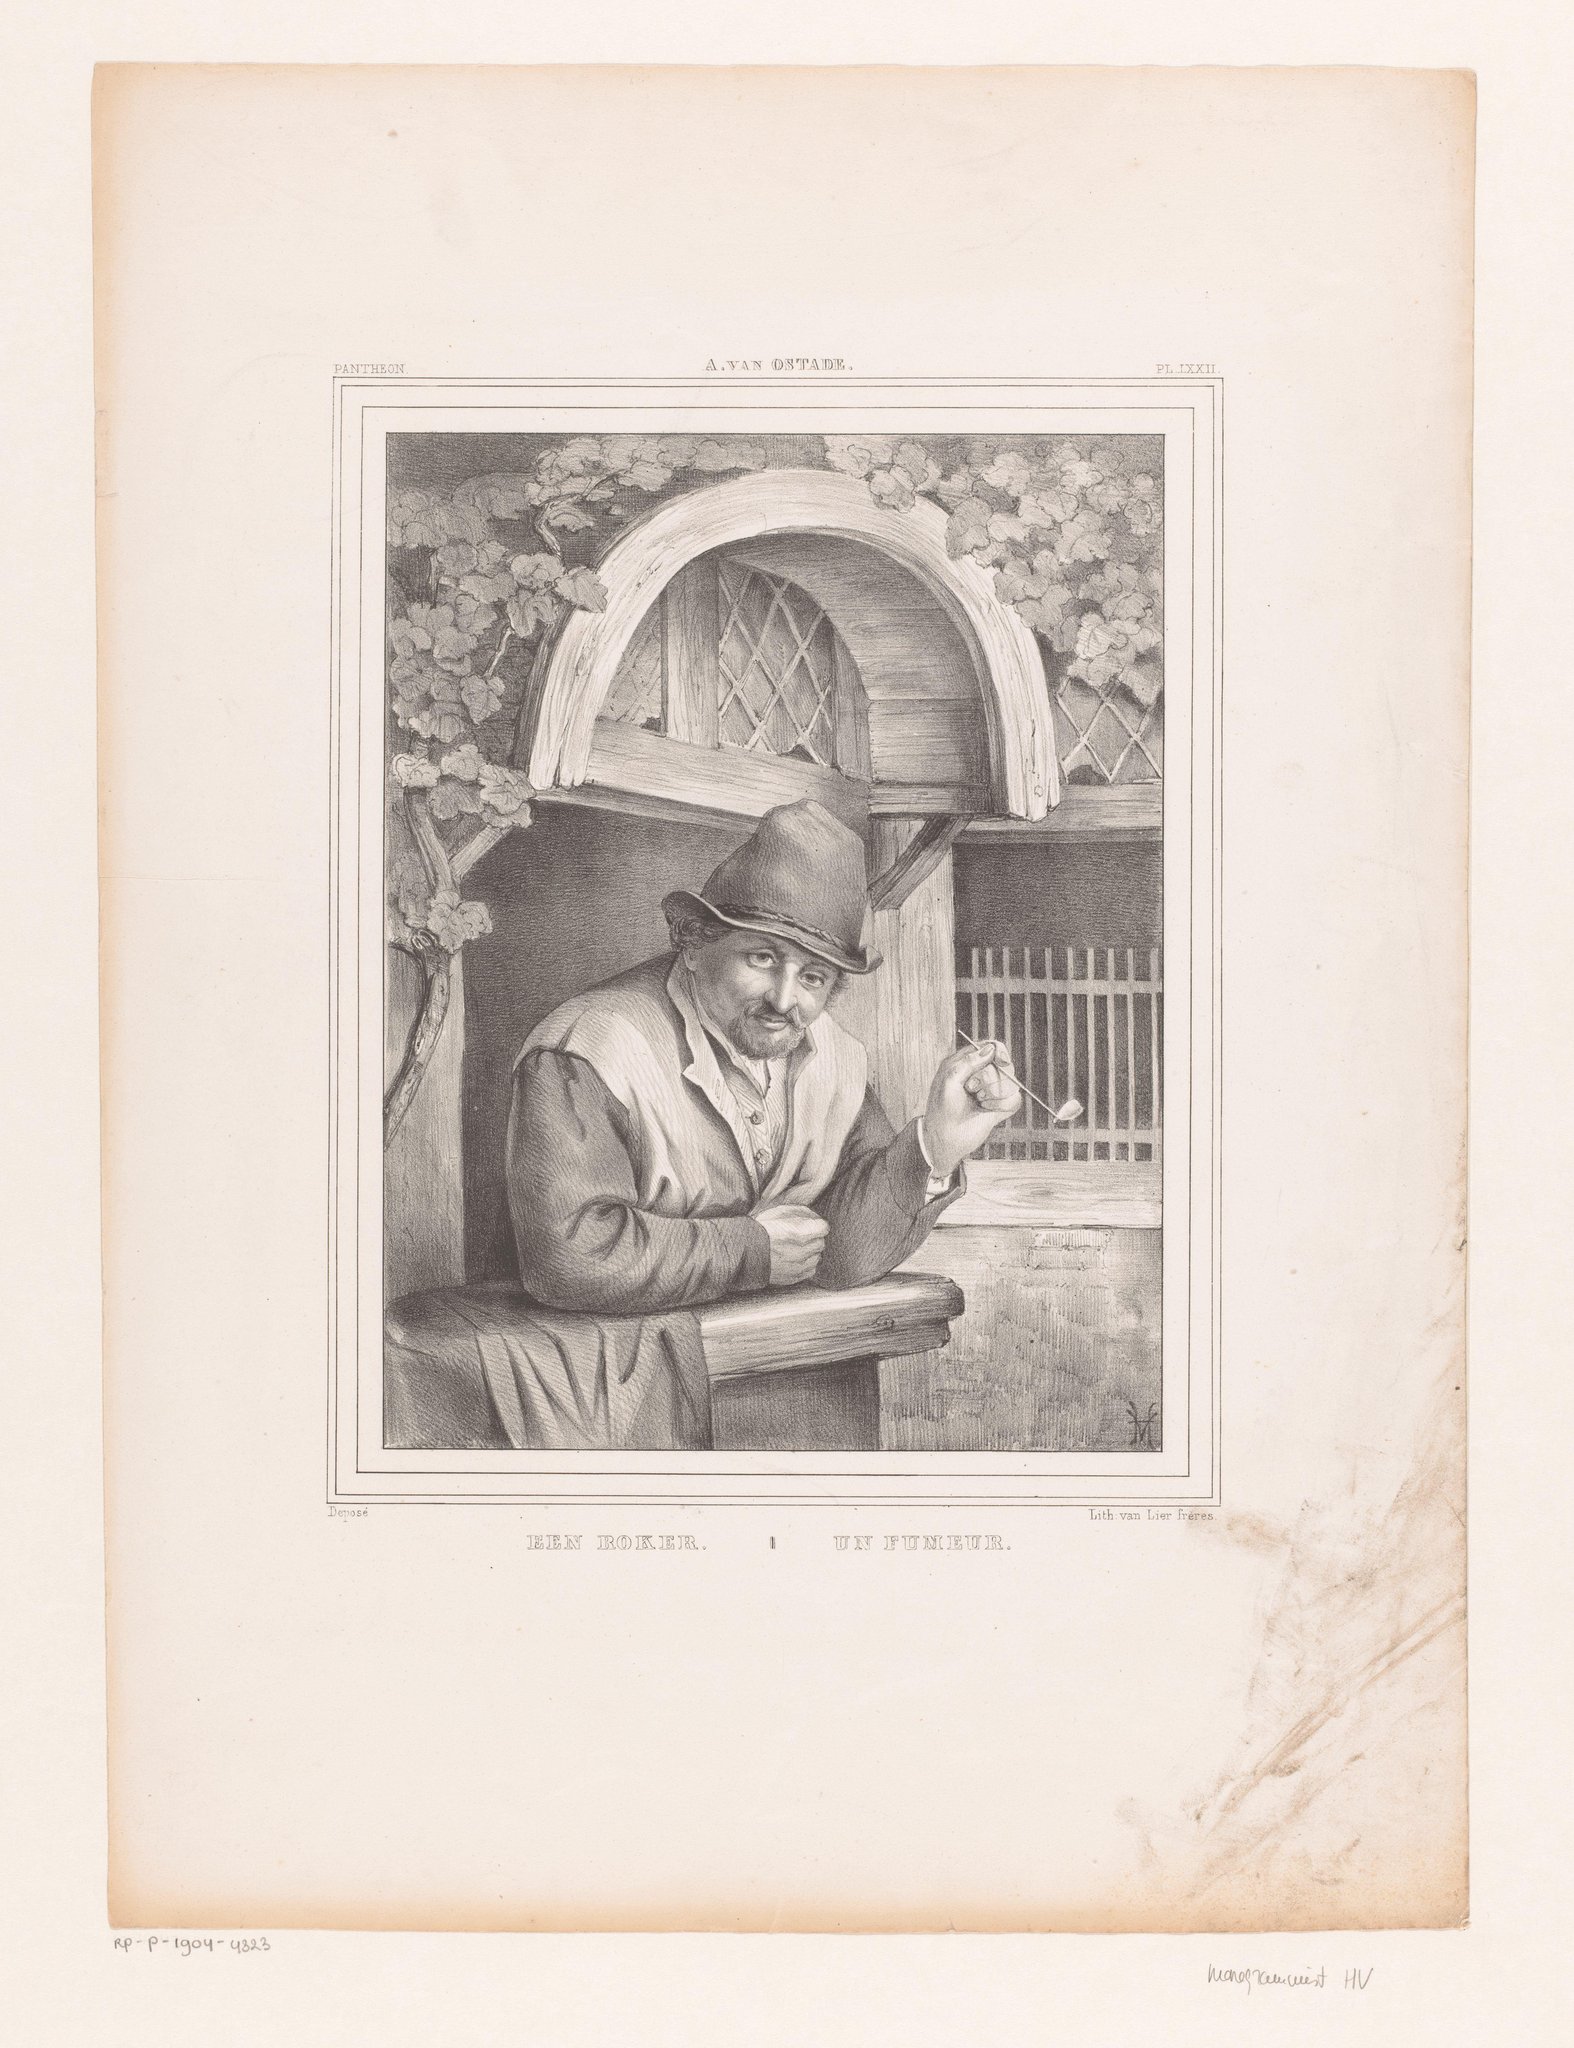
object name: print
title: Pantheon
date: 1837-1843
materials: paper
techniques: lithograph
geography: the hague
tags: pipe ~ tobacco, human figure at (open) window, seen from outside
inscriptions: : ‘Deposé’, collector's mark: Lugt 2228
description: Deze prent maakte mogelijk deel uit van: Pantheon of de tempel der onsterfelijkheid van Nederlandse kunstschilders. Uitgegeven door Gebroeders Van Lier in Amsterdam tussen 1837 en (in ieder geval) 1843.